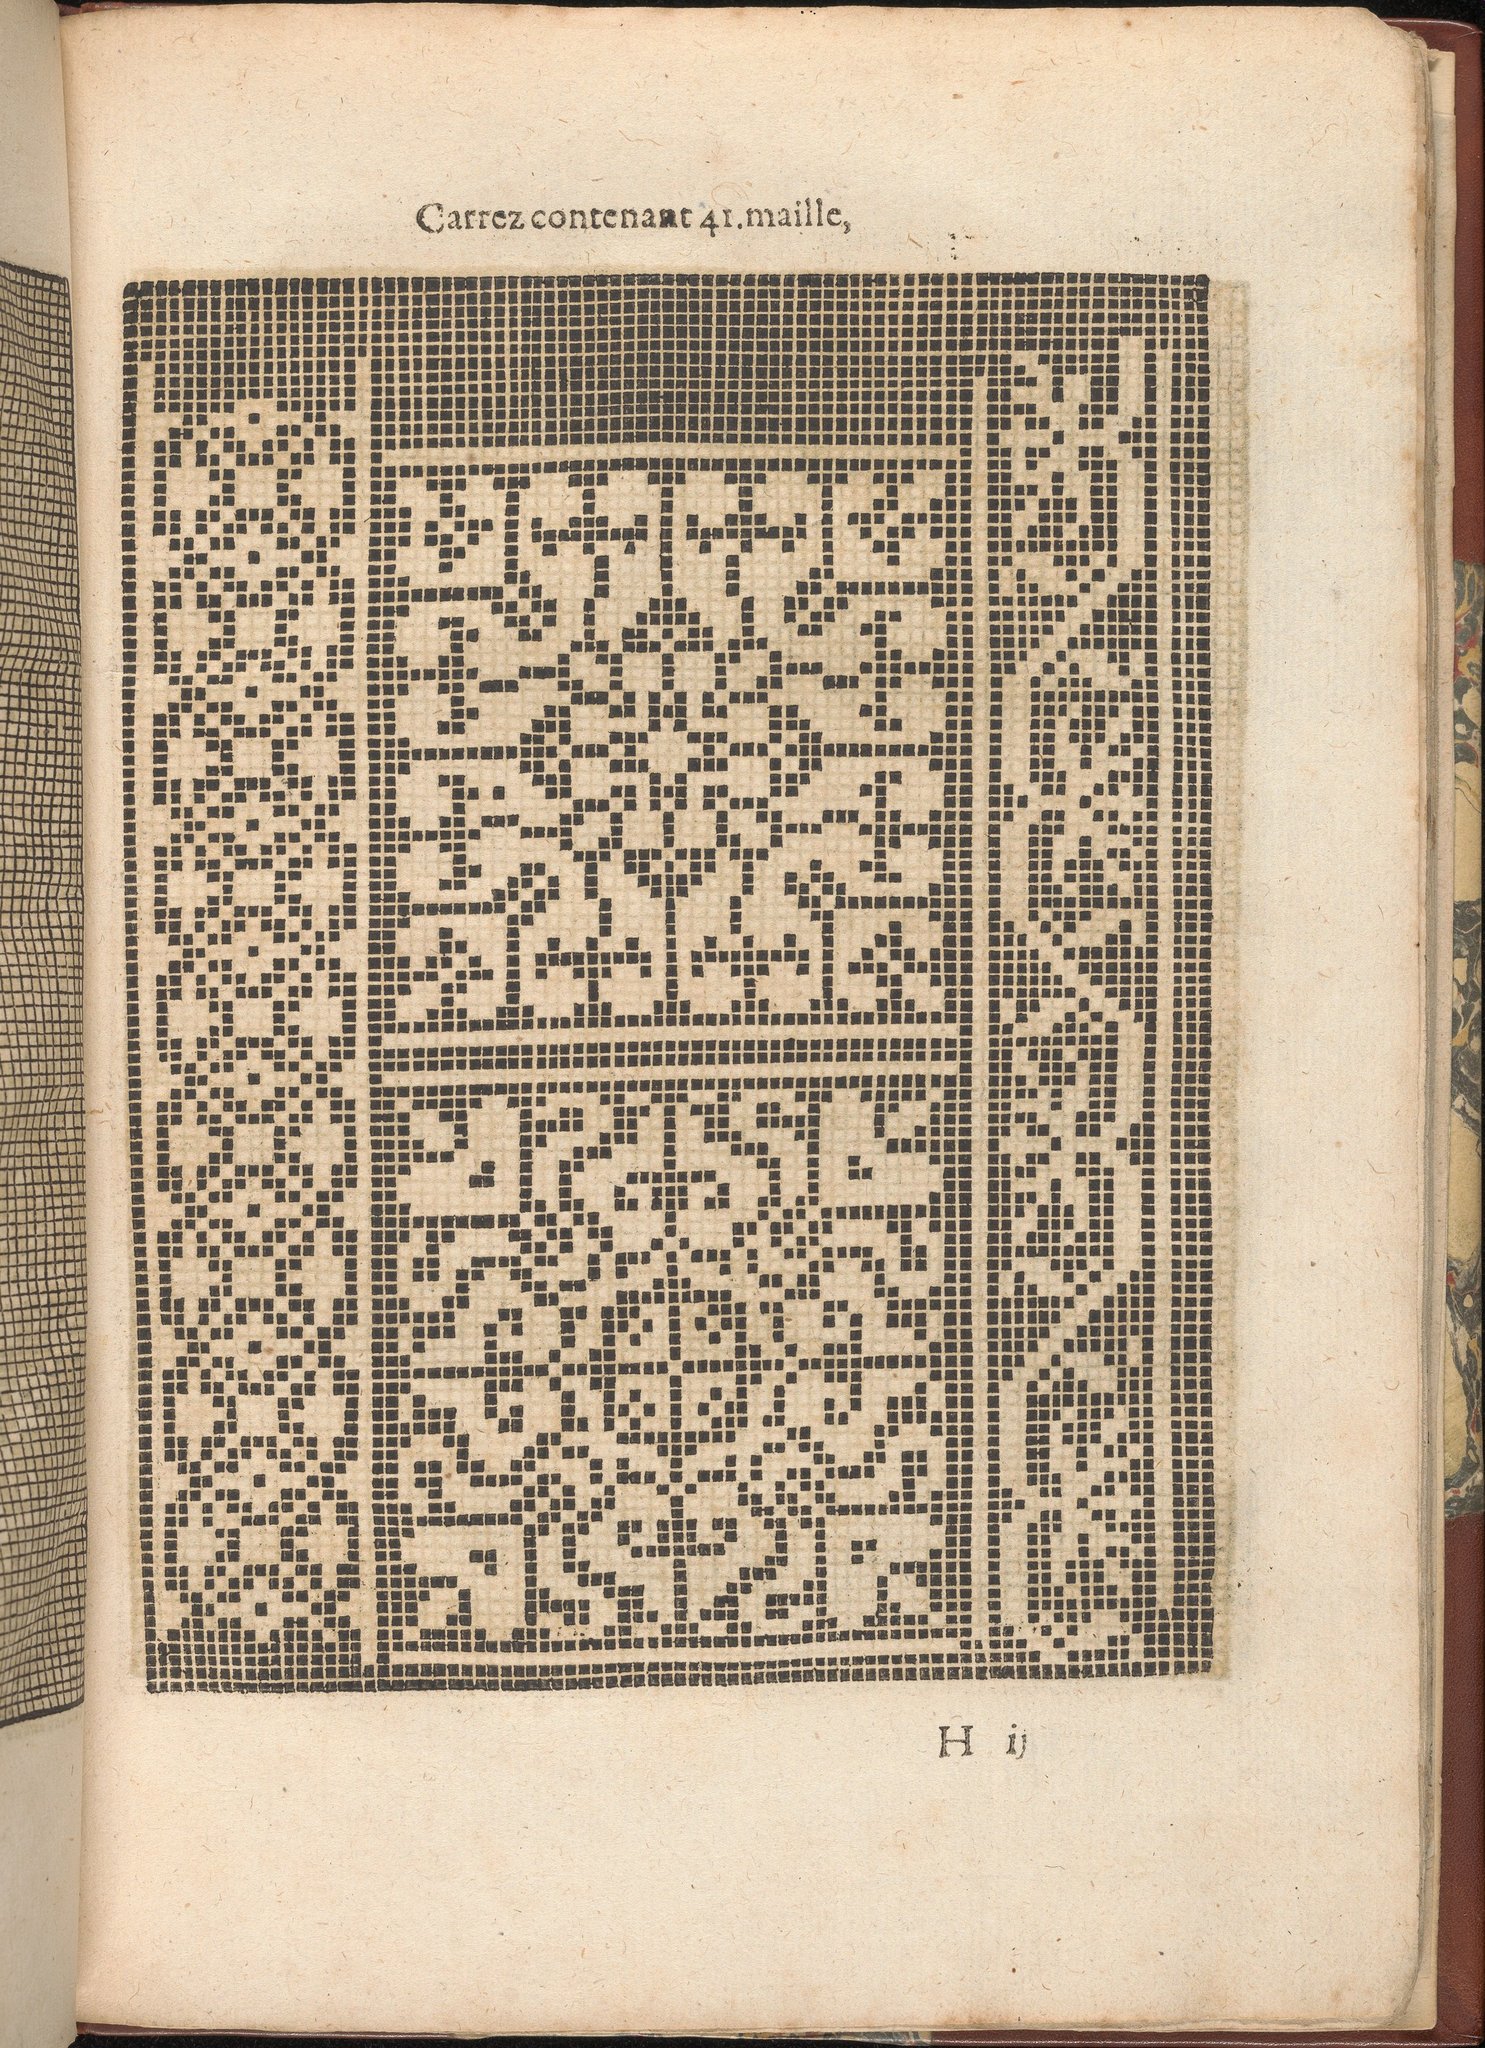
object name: book print ornament architecture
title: Les Secondes Oeuvres, et Subtiles Inventions De Lingerie du Seigneur Federic de Vinciolo Venitien, page 30 (recto)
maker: federico de vinciolo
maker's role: designer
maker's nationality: italian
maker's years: 1582-1599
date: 1603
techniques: woodcut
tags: ornament